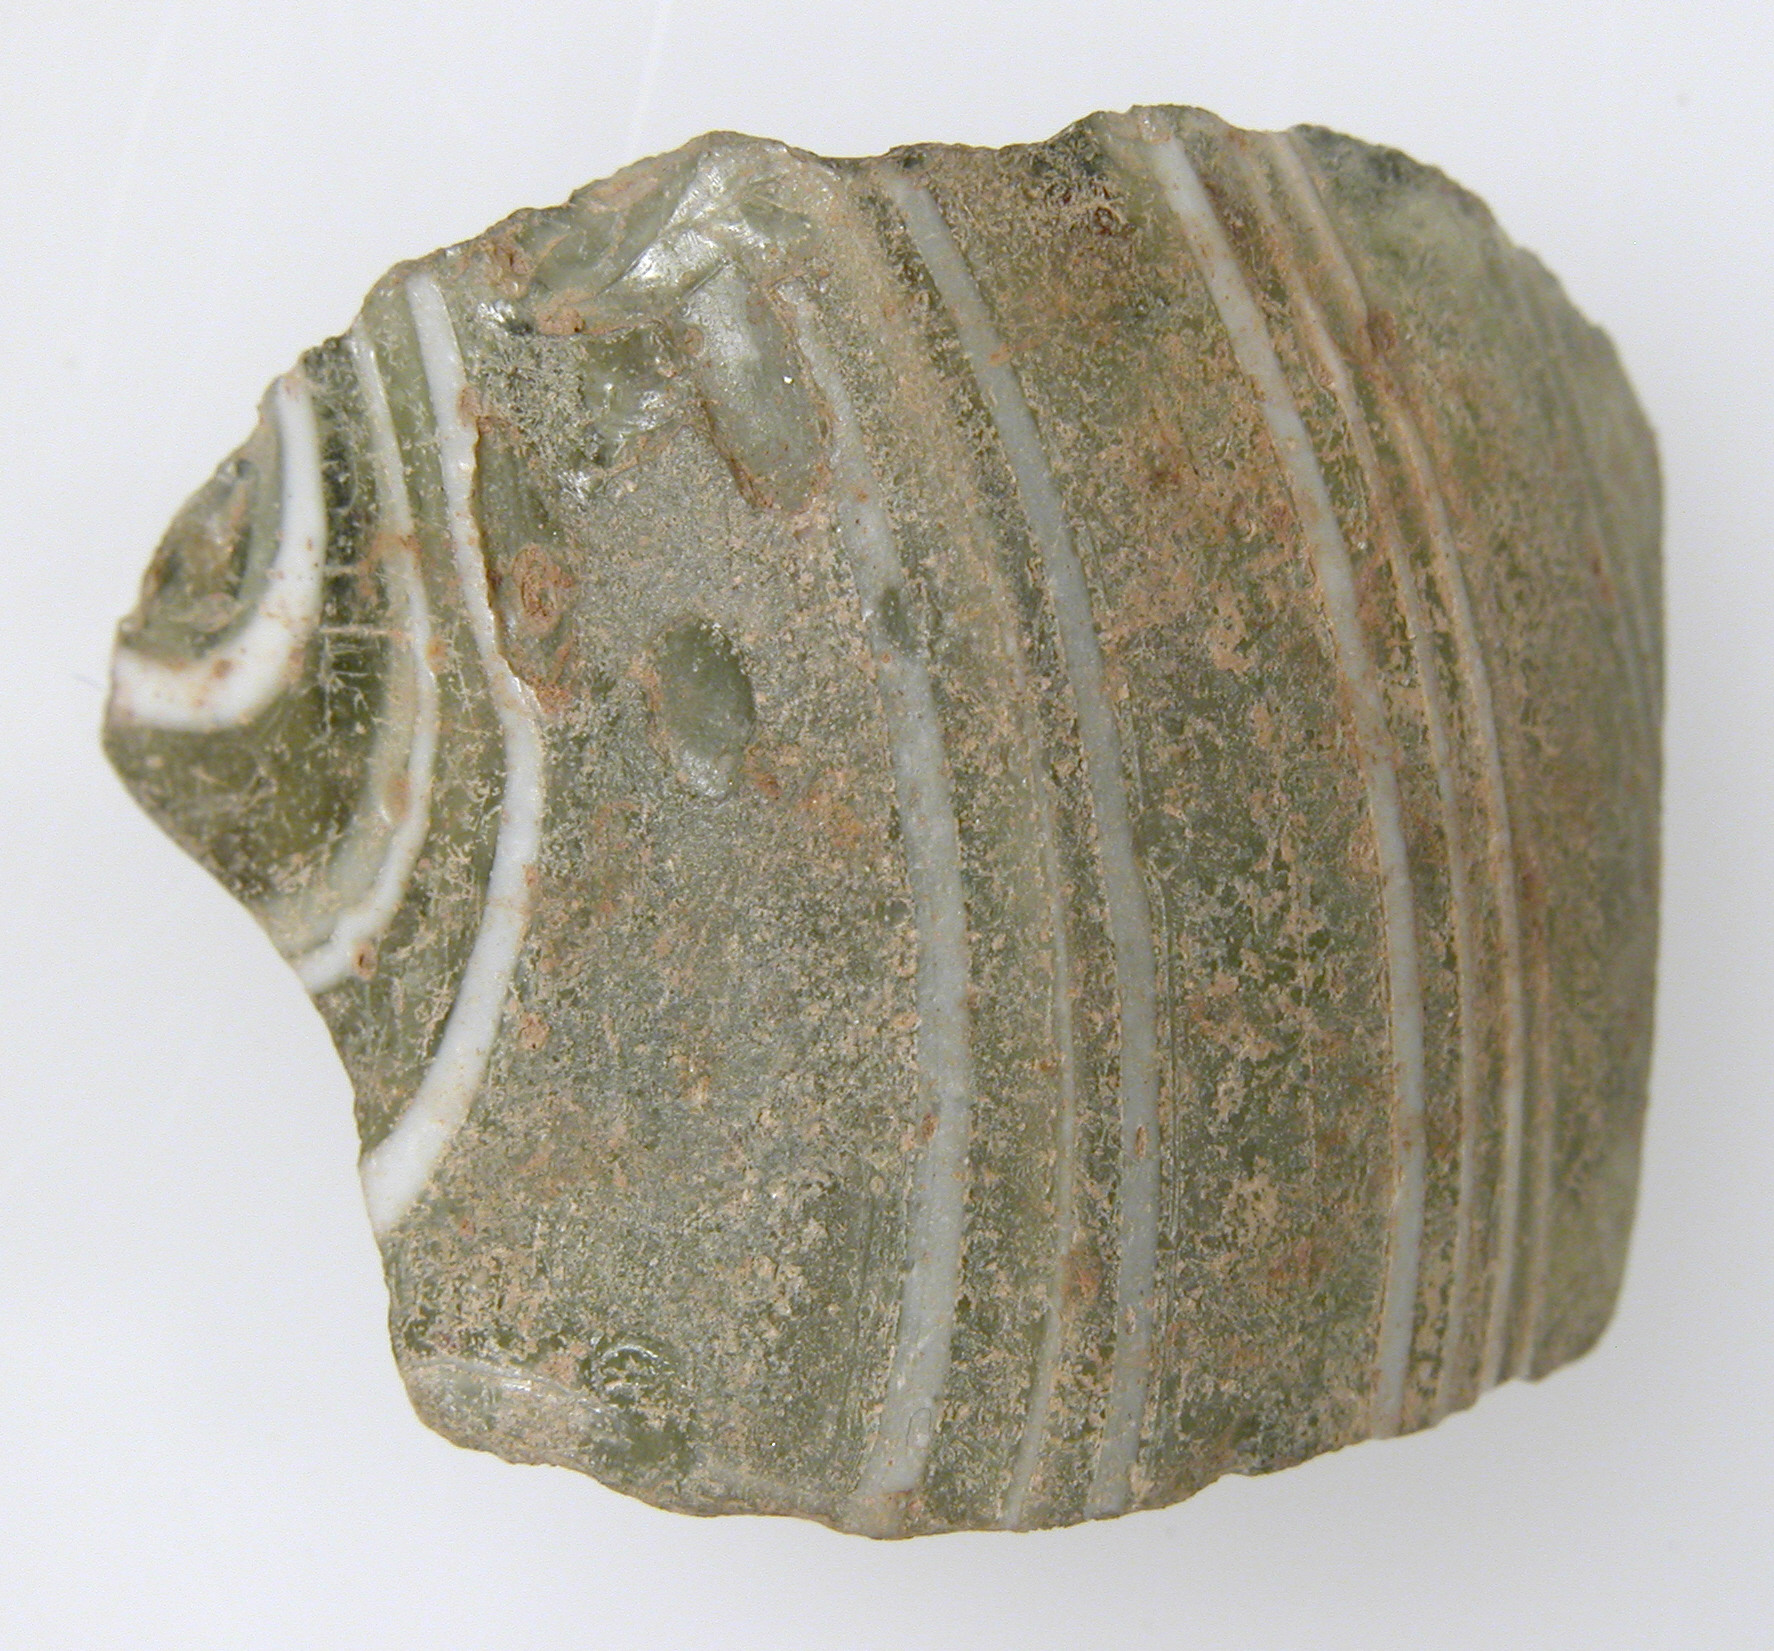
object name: fragment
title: Glass Fragment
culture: coptic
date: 301-433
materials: glass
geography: egypt